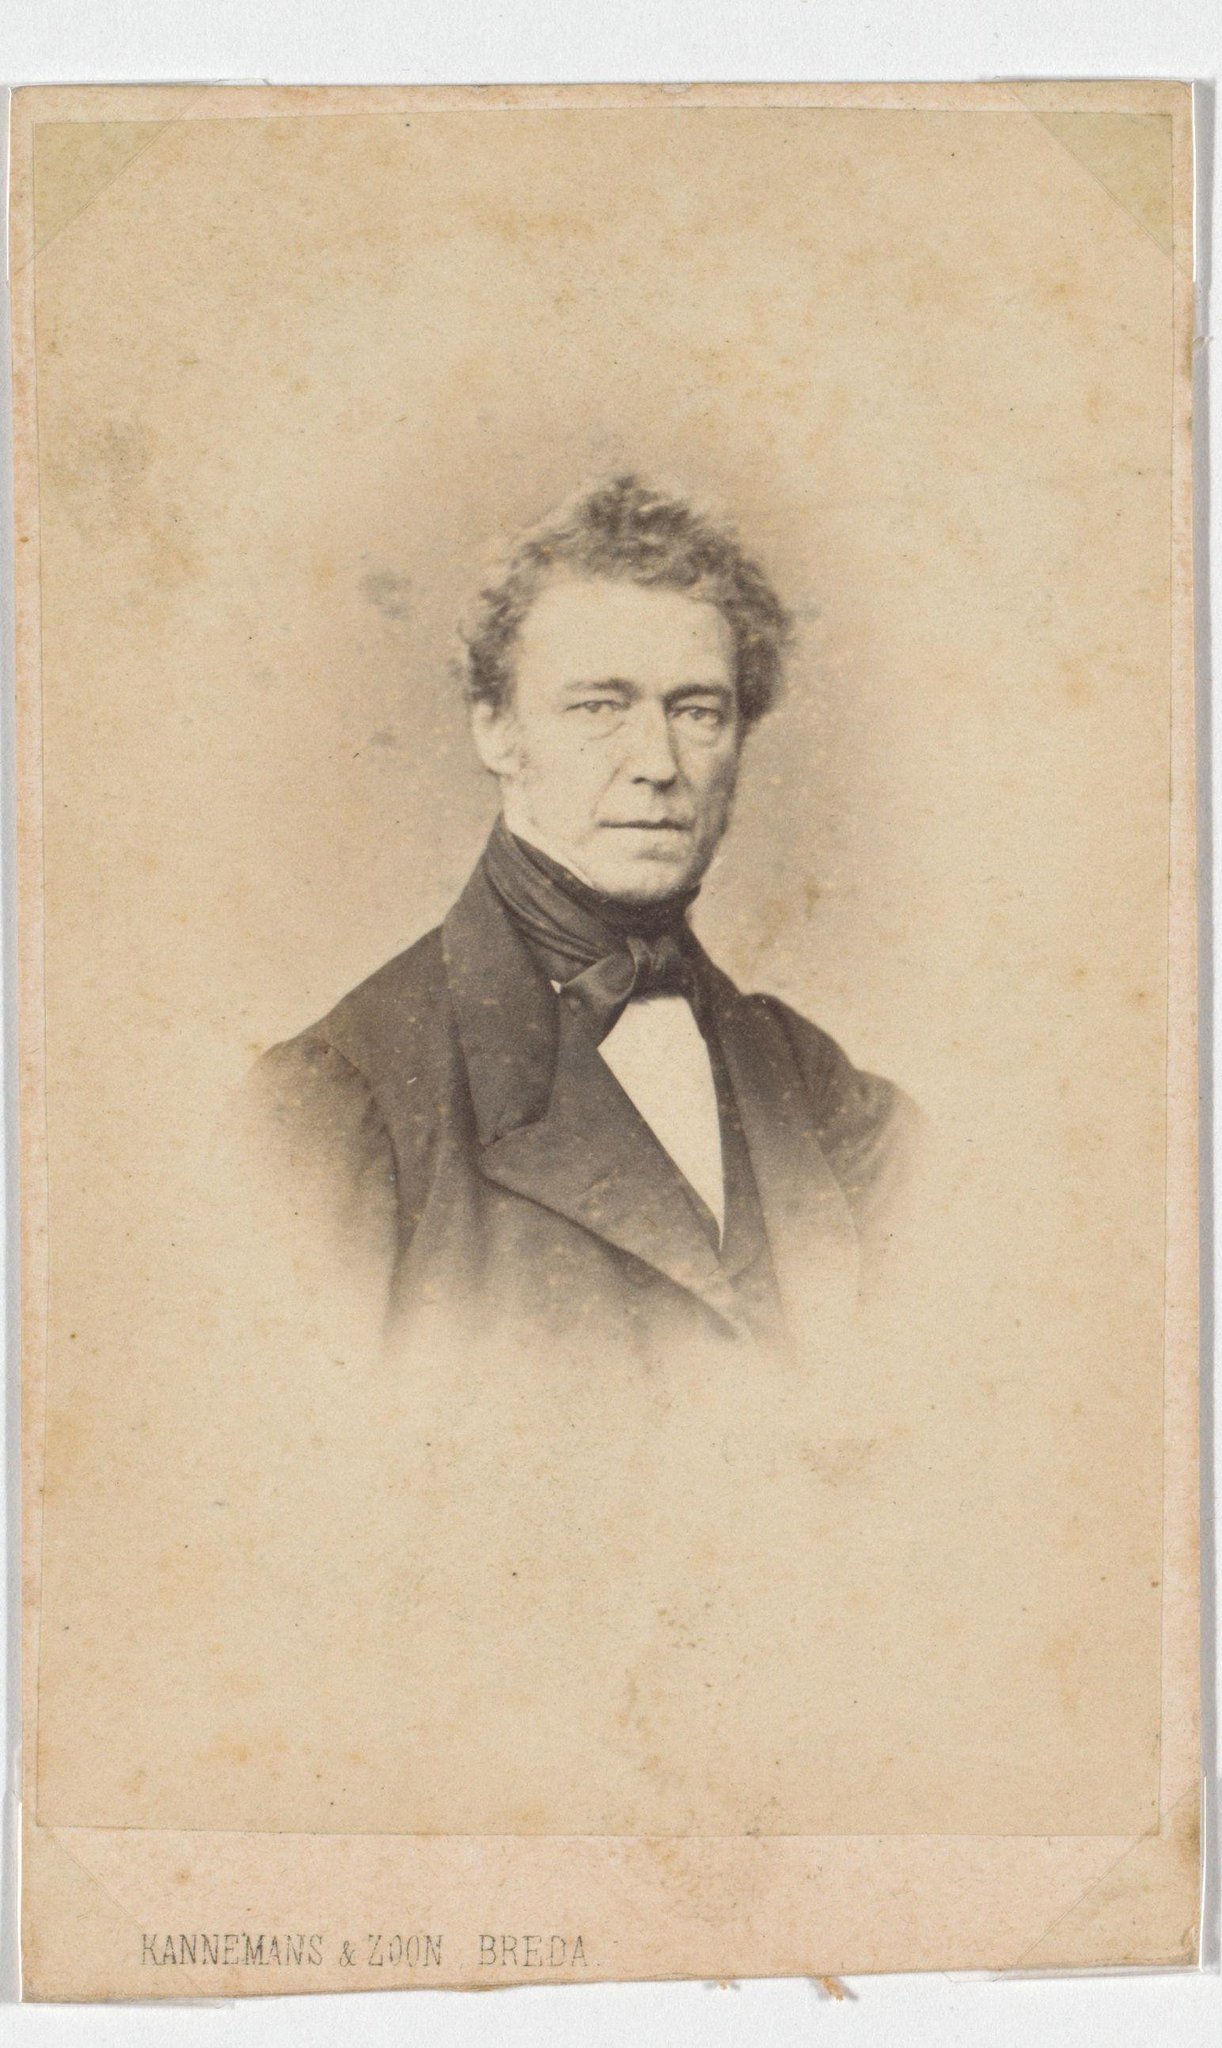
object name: photograph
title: Portret van een man met een das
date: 1860-1884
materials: cardboard, paper, photographic support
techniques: albumen print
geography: breda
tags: studio requisites ~ photographer, historical persons not known by name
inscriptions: address: ‘Breda Groote Markt D.15 tegen over het stadhuis’